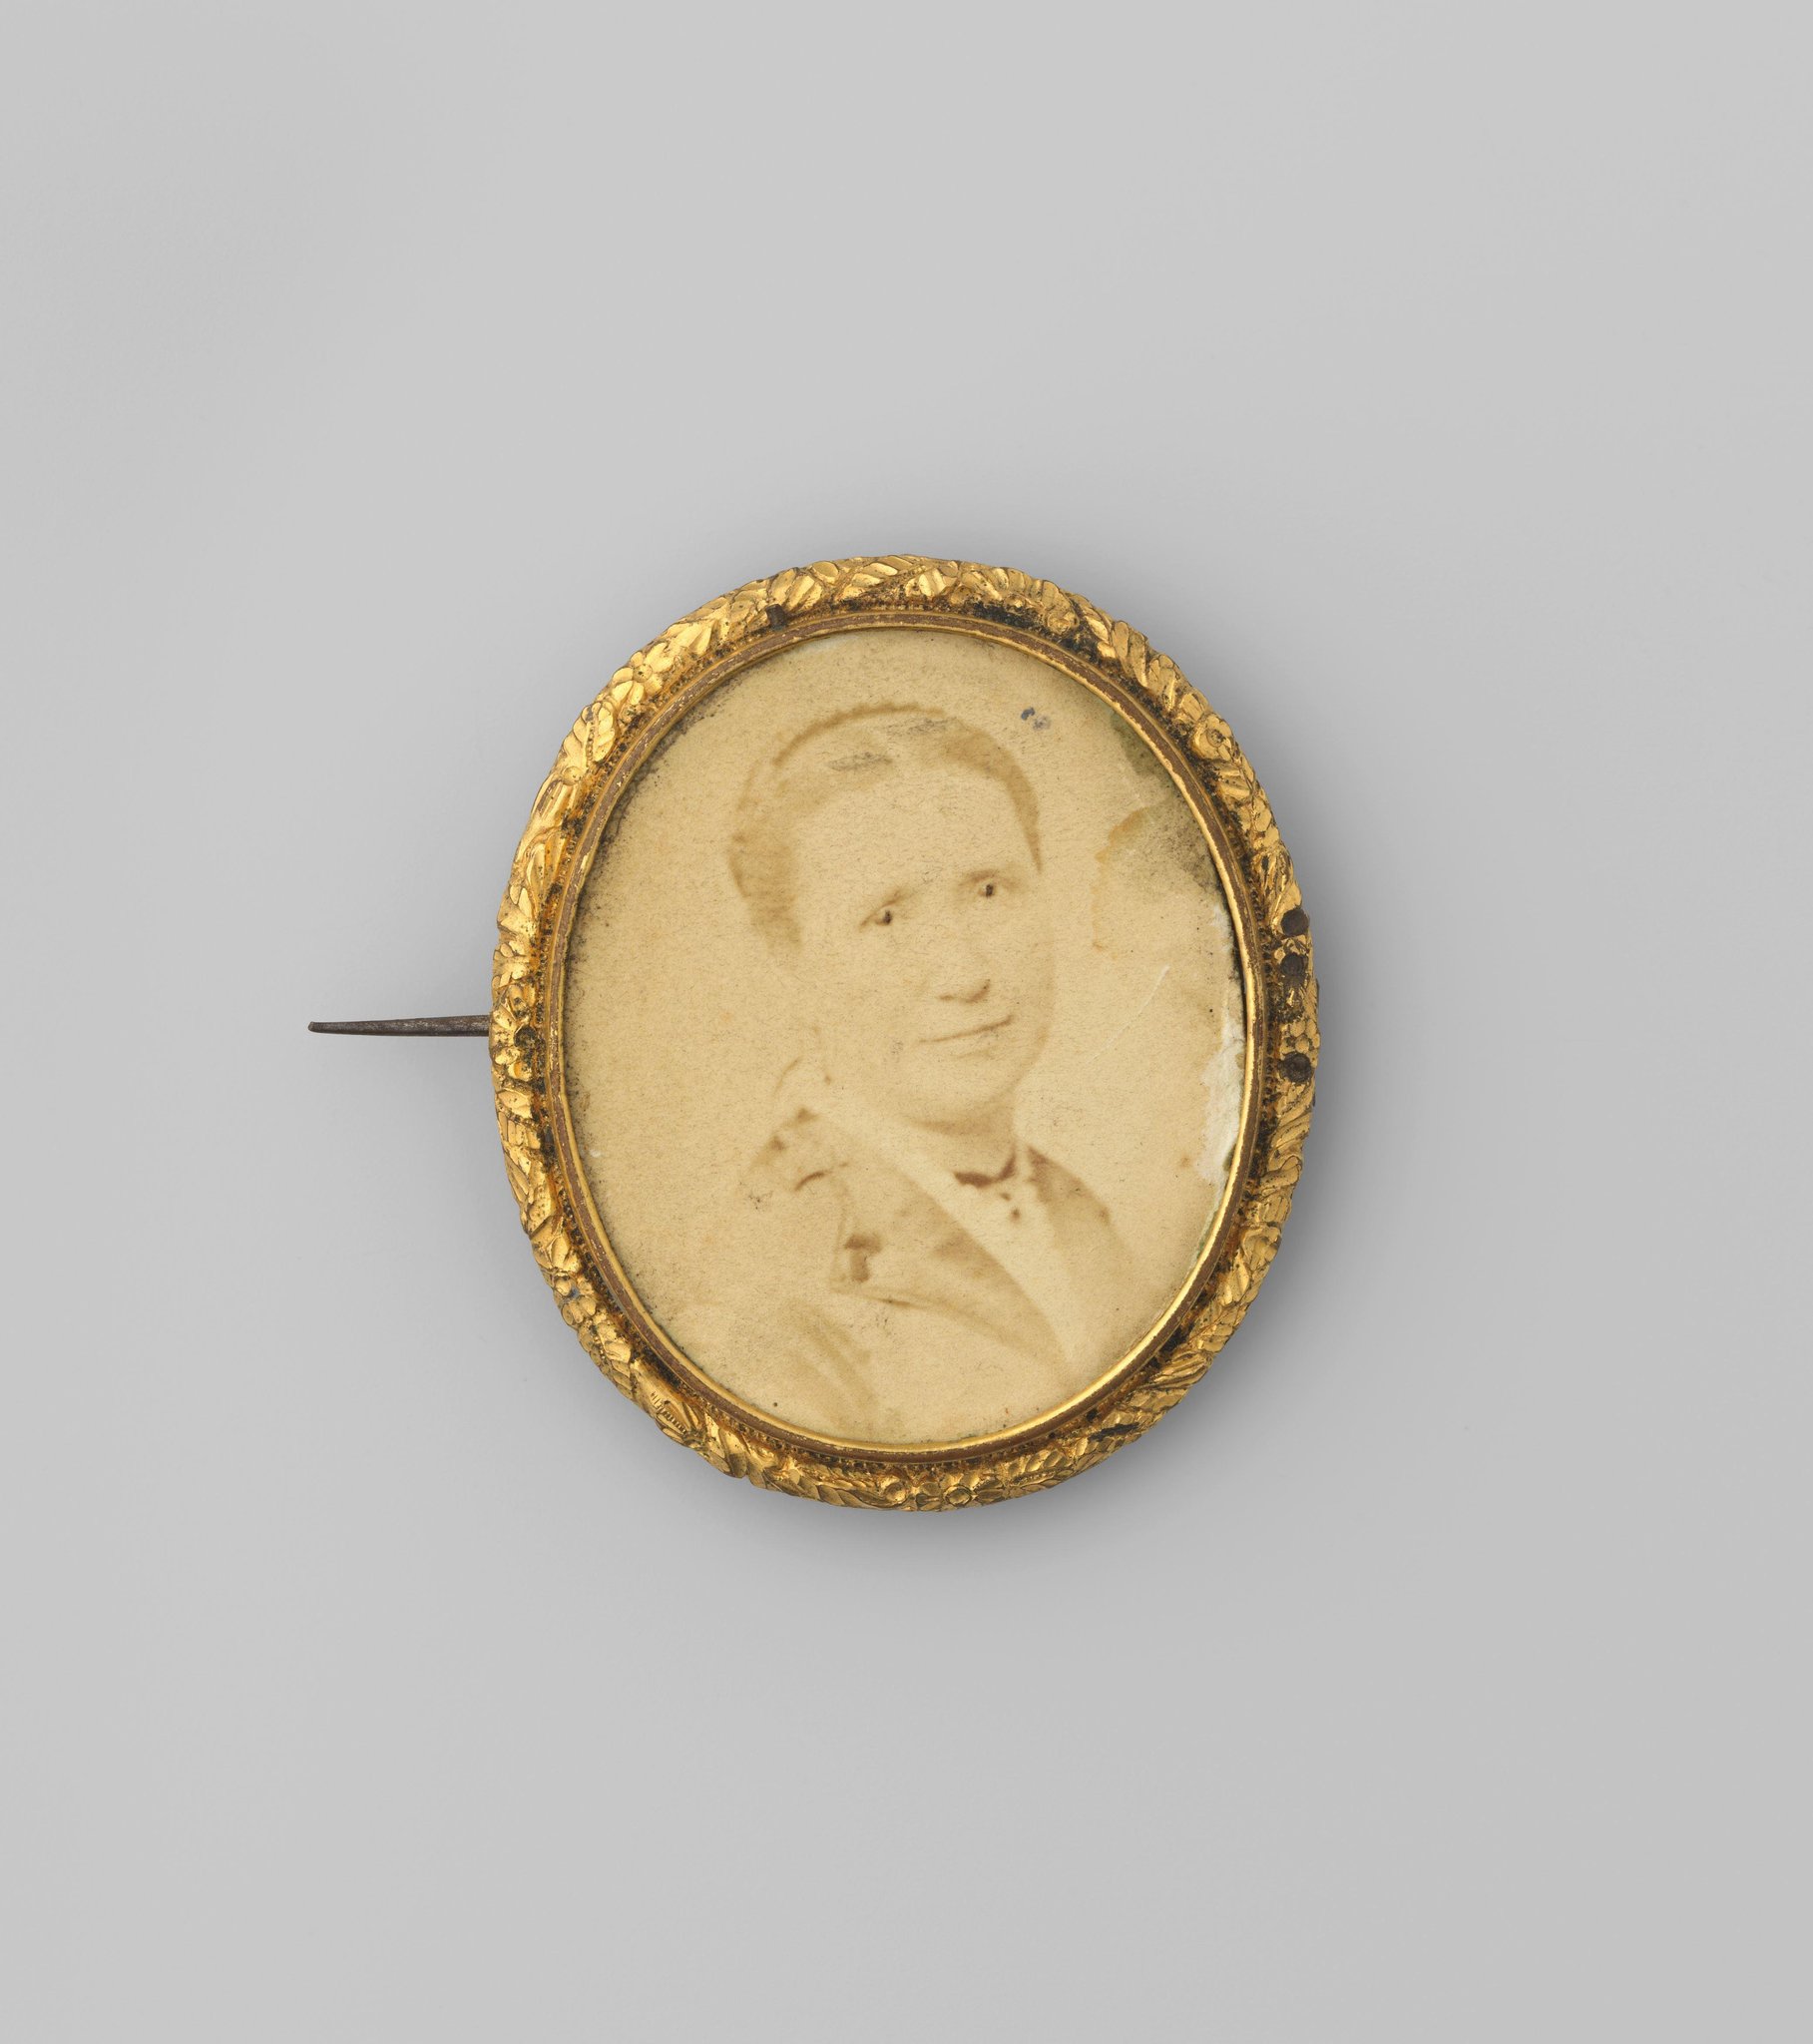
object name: brooch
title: Portret van een onbekende vrouw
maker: Anonymous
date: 1851-1900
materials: metal, paper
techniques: albumen print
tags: anonymous historical person portrayed - bb - woman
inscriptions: inscription: ‘nov 79 Parijs/ [...]/ ff 30-/ (à f 0,47)’